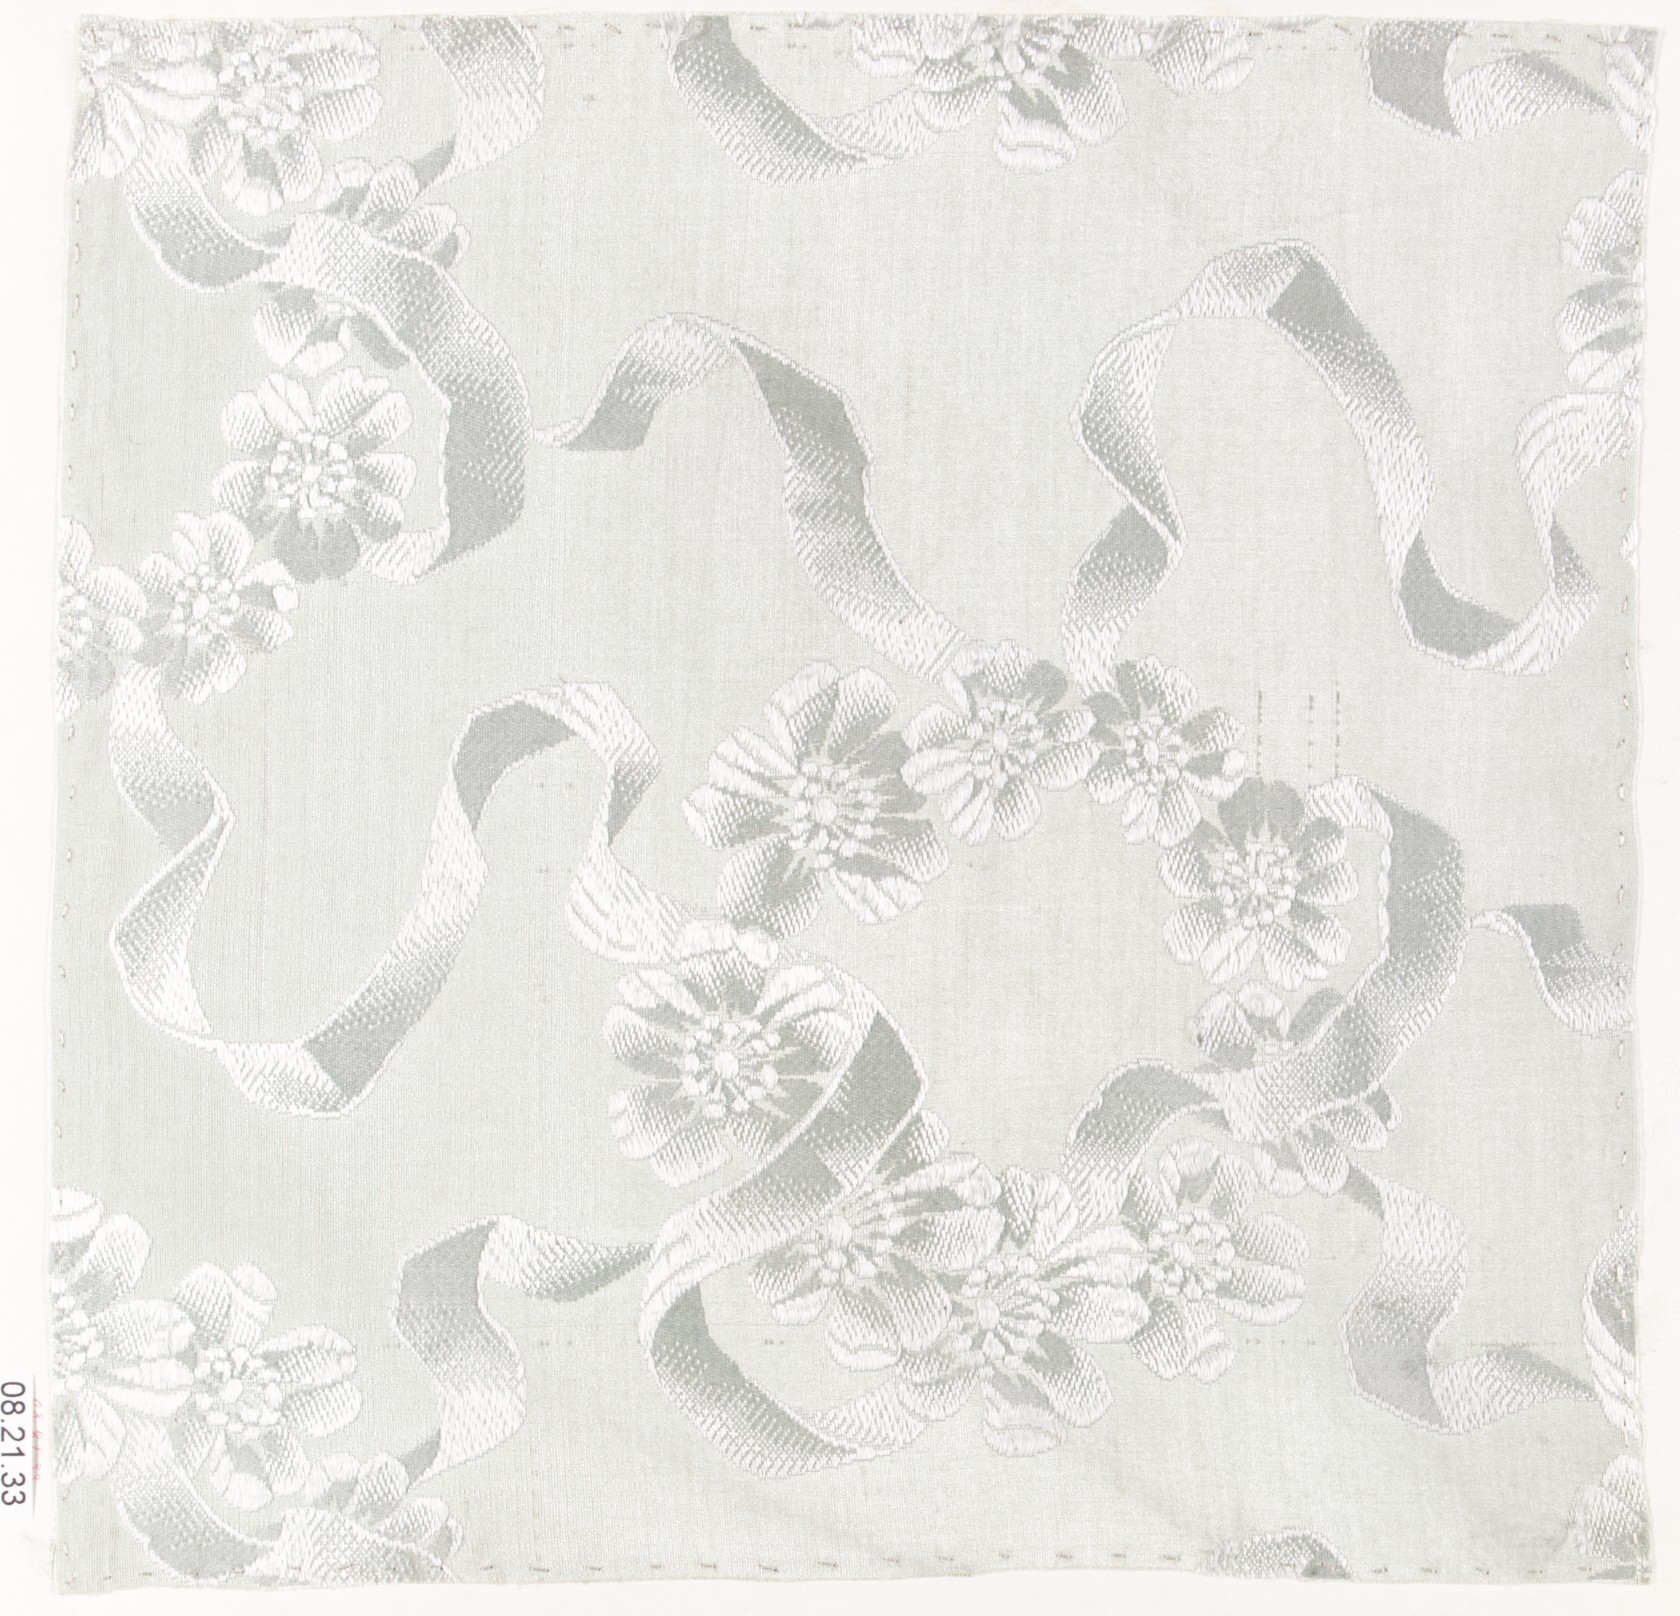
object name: textile sample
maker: Anonymous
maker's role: designer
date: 1900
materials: silk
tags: flowers